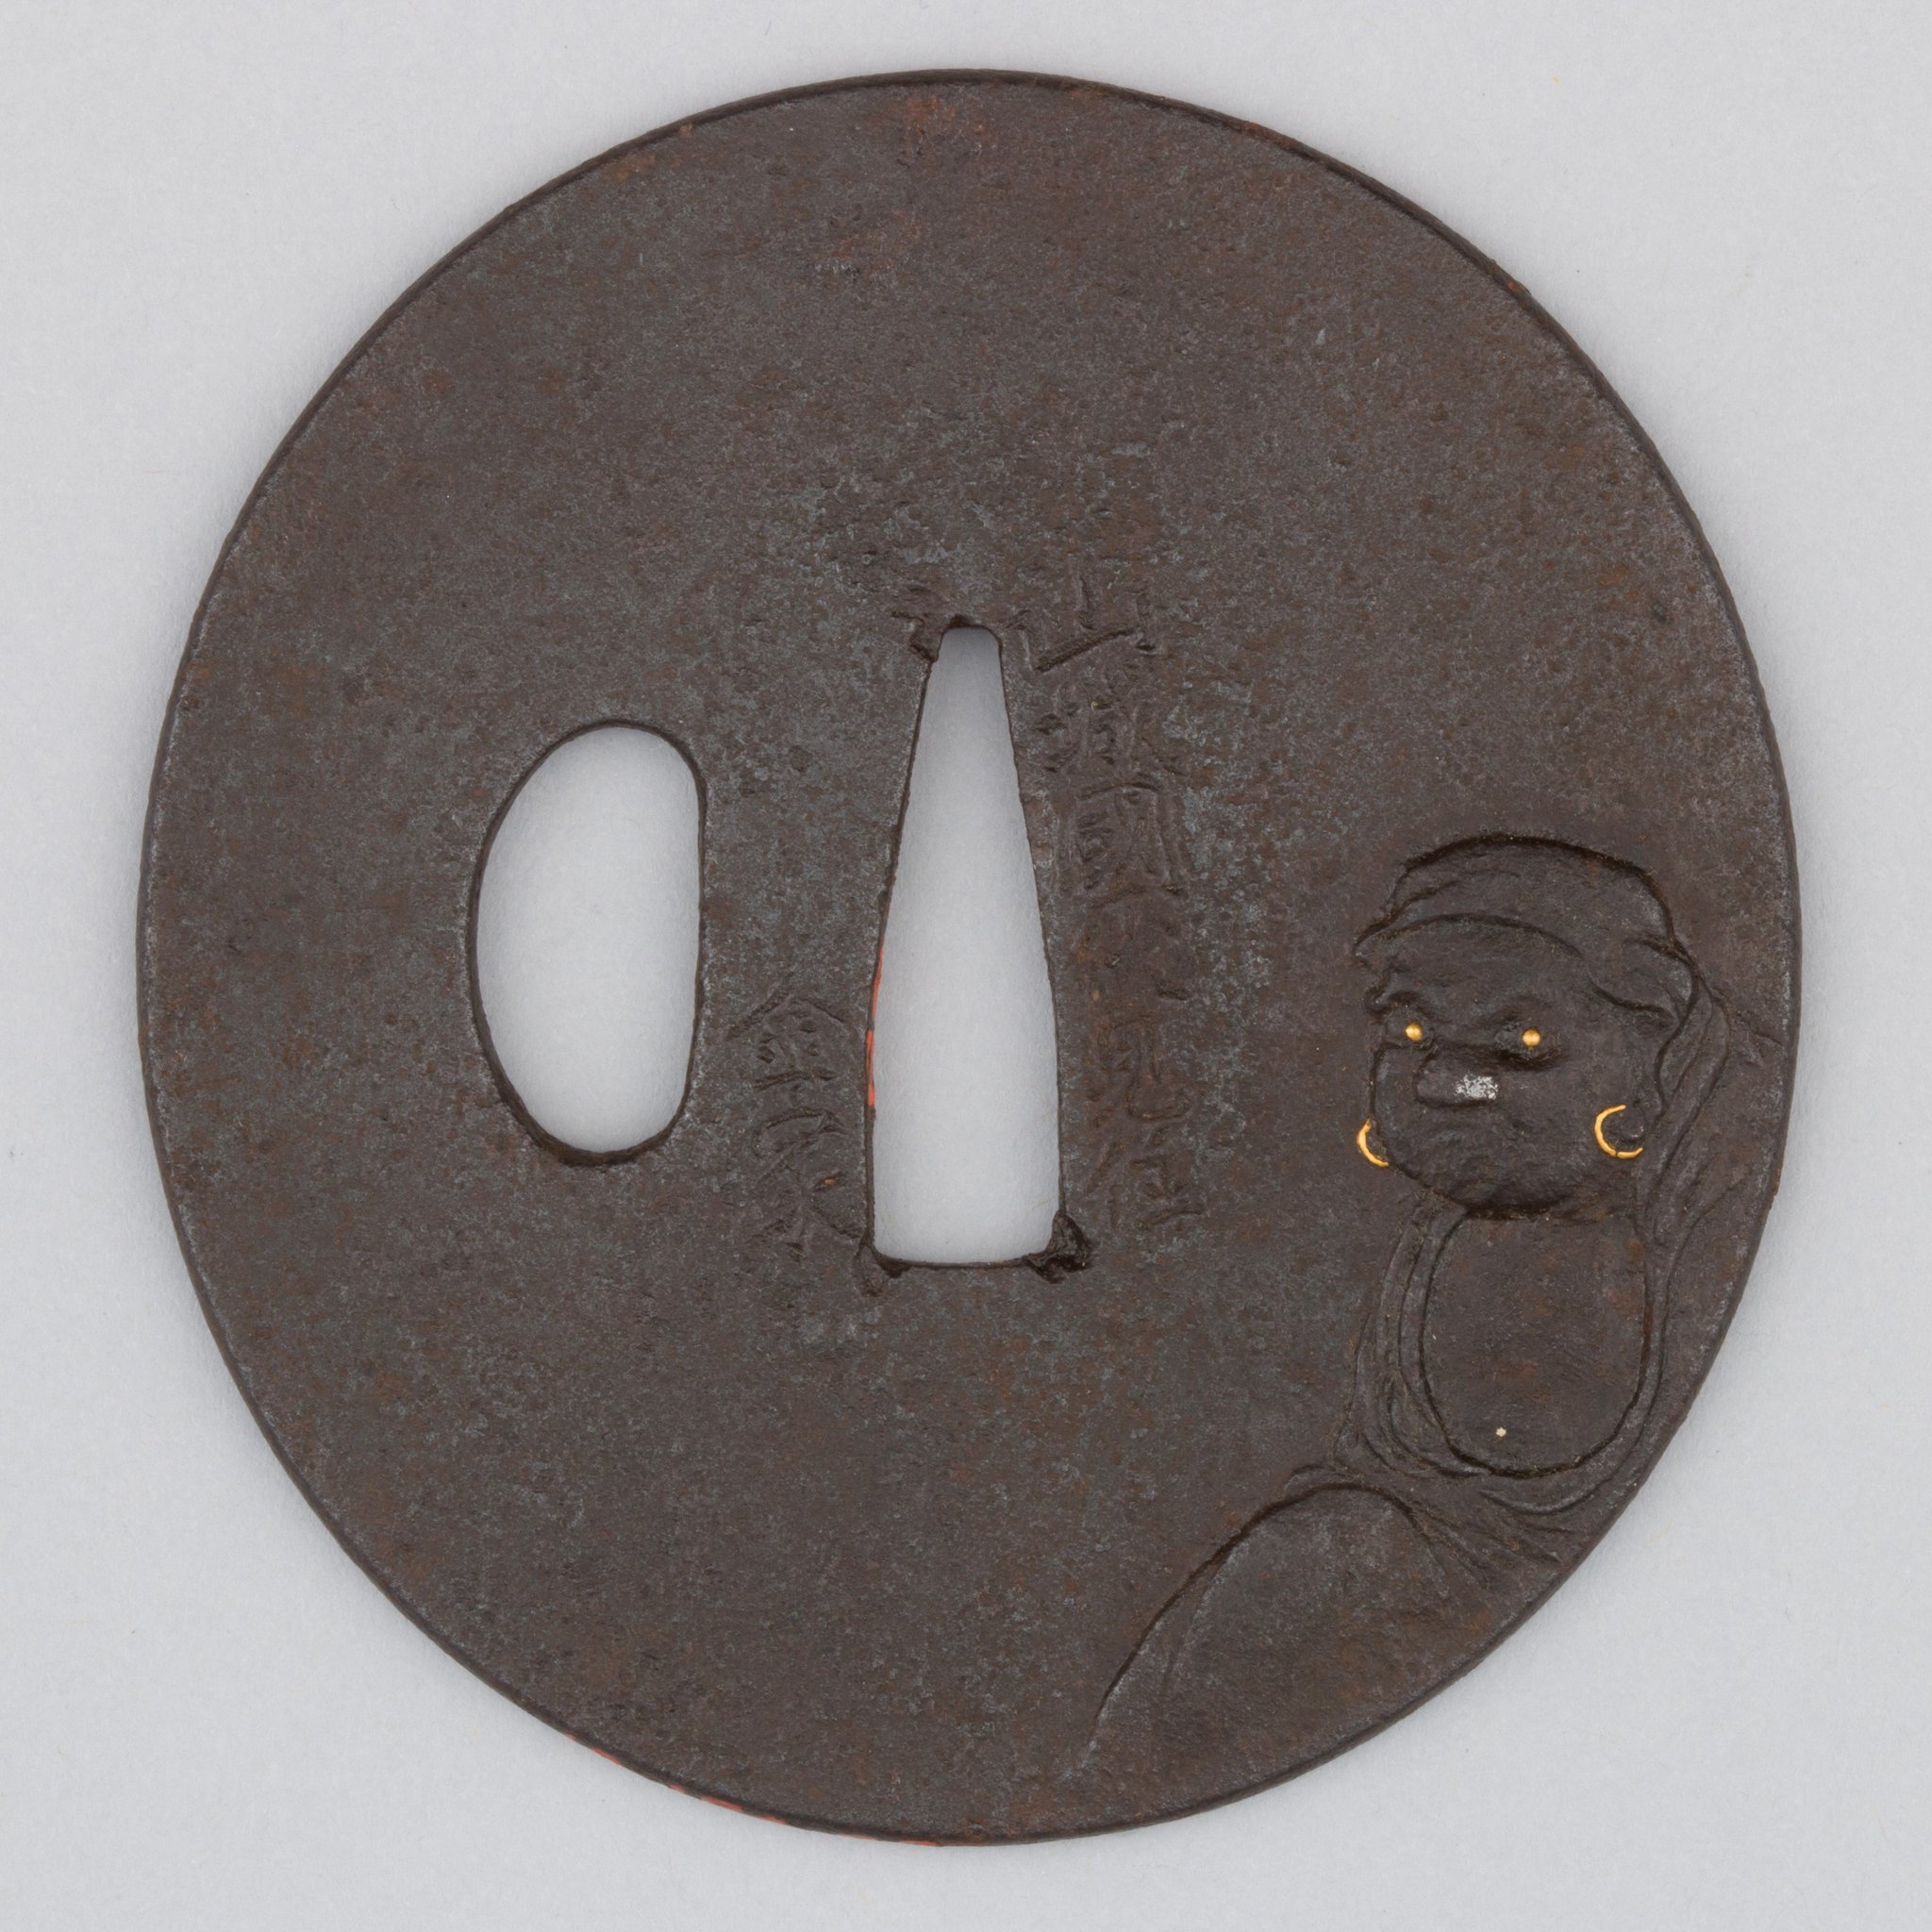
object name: sword guard tsuba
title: Sword Guard (Tsuba)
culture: japanese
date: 1615-1868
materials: copper, iron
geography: japan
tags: men